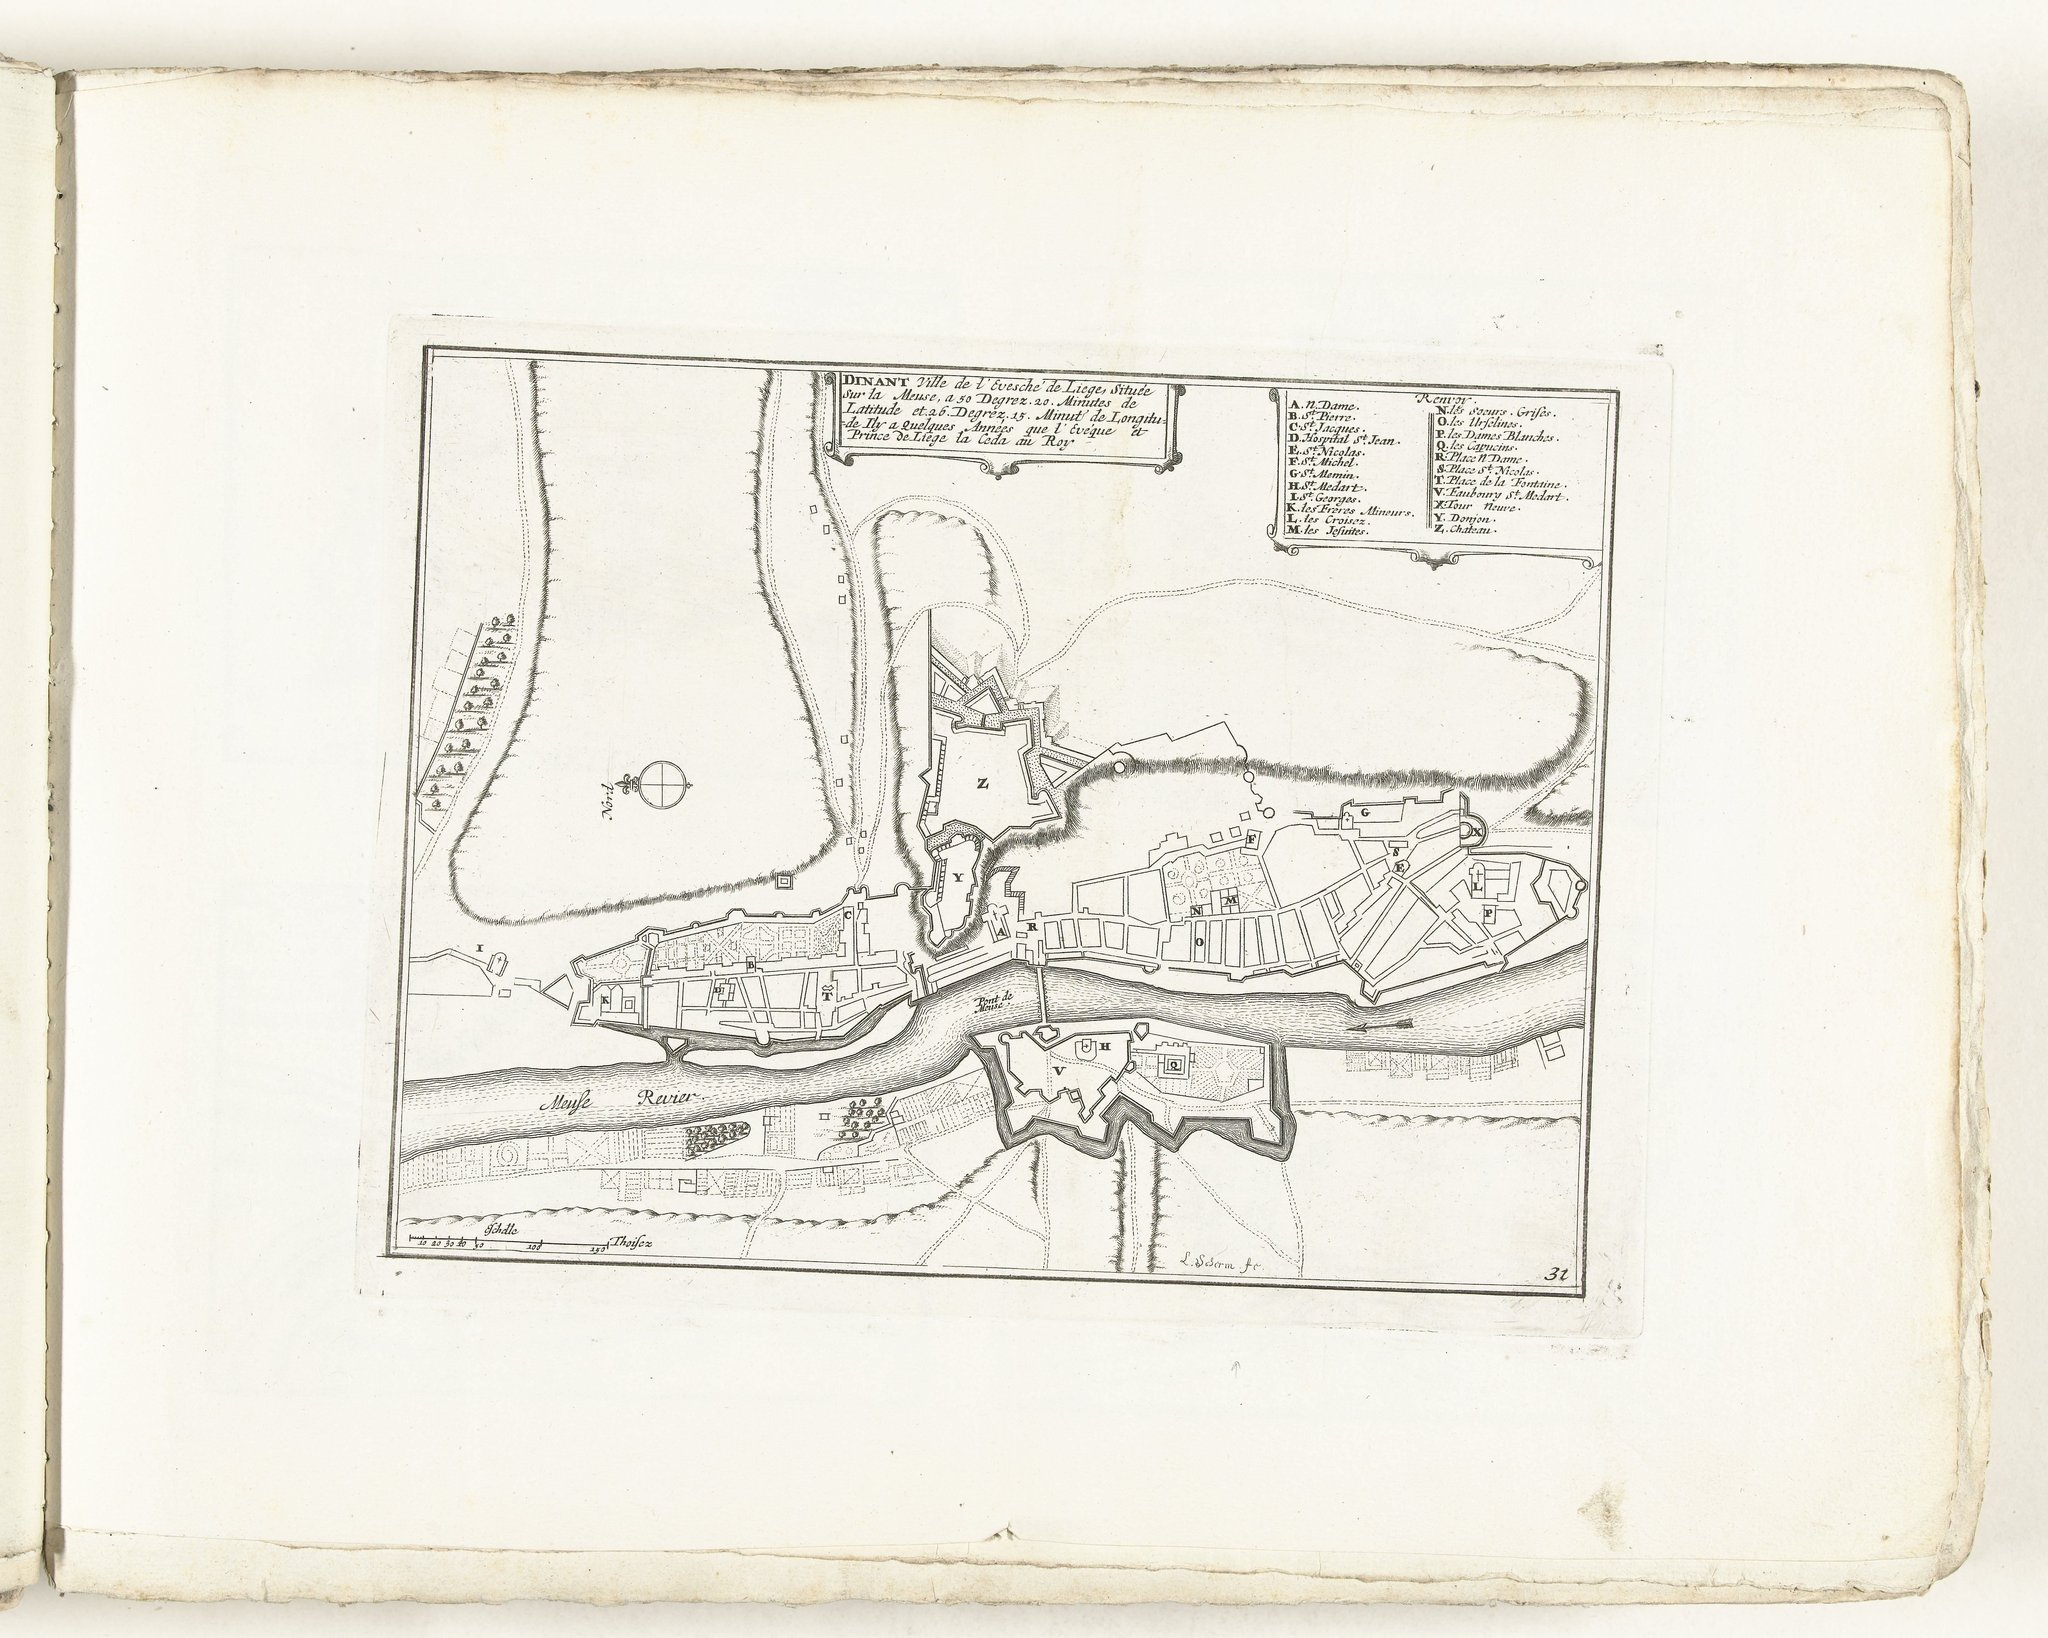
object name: map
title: Les Forces de l'Europe, Asie, Afrique et Amerique, ou description des principales villes avec leurs fortifications. Dessignées par les meilleurs ingenieurs, particulierement celles qui sont sous la domination de la France (...) et ornées de plusieurs superbes edifices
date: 1702-1703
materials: paper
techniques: etching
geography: northern netherlands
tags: fortress, maps of cities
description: Plattegrond van de verdedigingswerken om de stad Dinant in de provincie Luik. Plaat nr. 31 in het prentwerk bestaande in totaal uit 276 genummerde platen van vermaarde sterke steden en vestingen in het kader van de Spaanse Successieoorlog. Voor het merendeel zijn deze platen gekopieerd naar de anonieme Franse platen: in Les forces de l'Europe en in: Le theatre de la guerre, dans les Pays-Bas, beide oorspronkelijk uitgegeven door Nicolas de Fer te Parijs (1693-1697) in het kader van de Negenjarige Oorlog. Titel en opschriften in de plaat in het Frans.